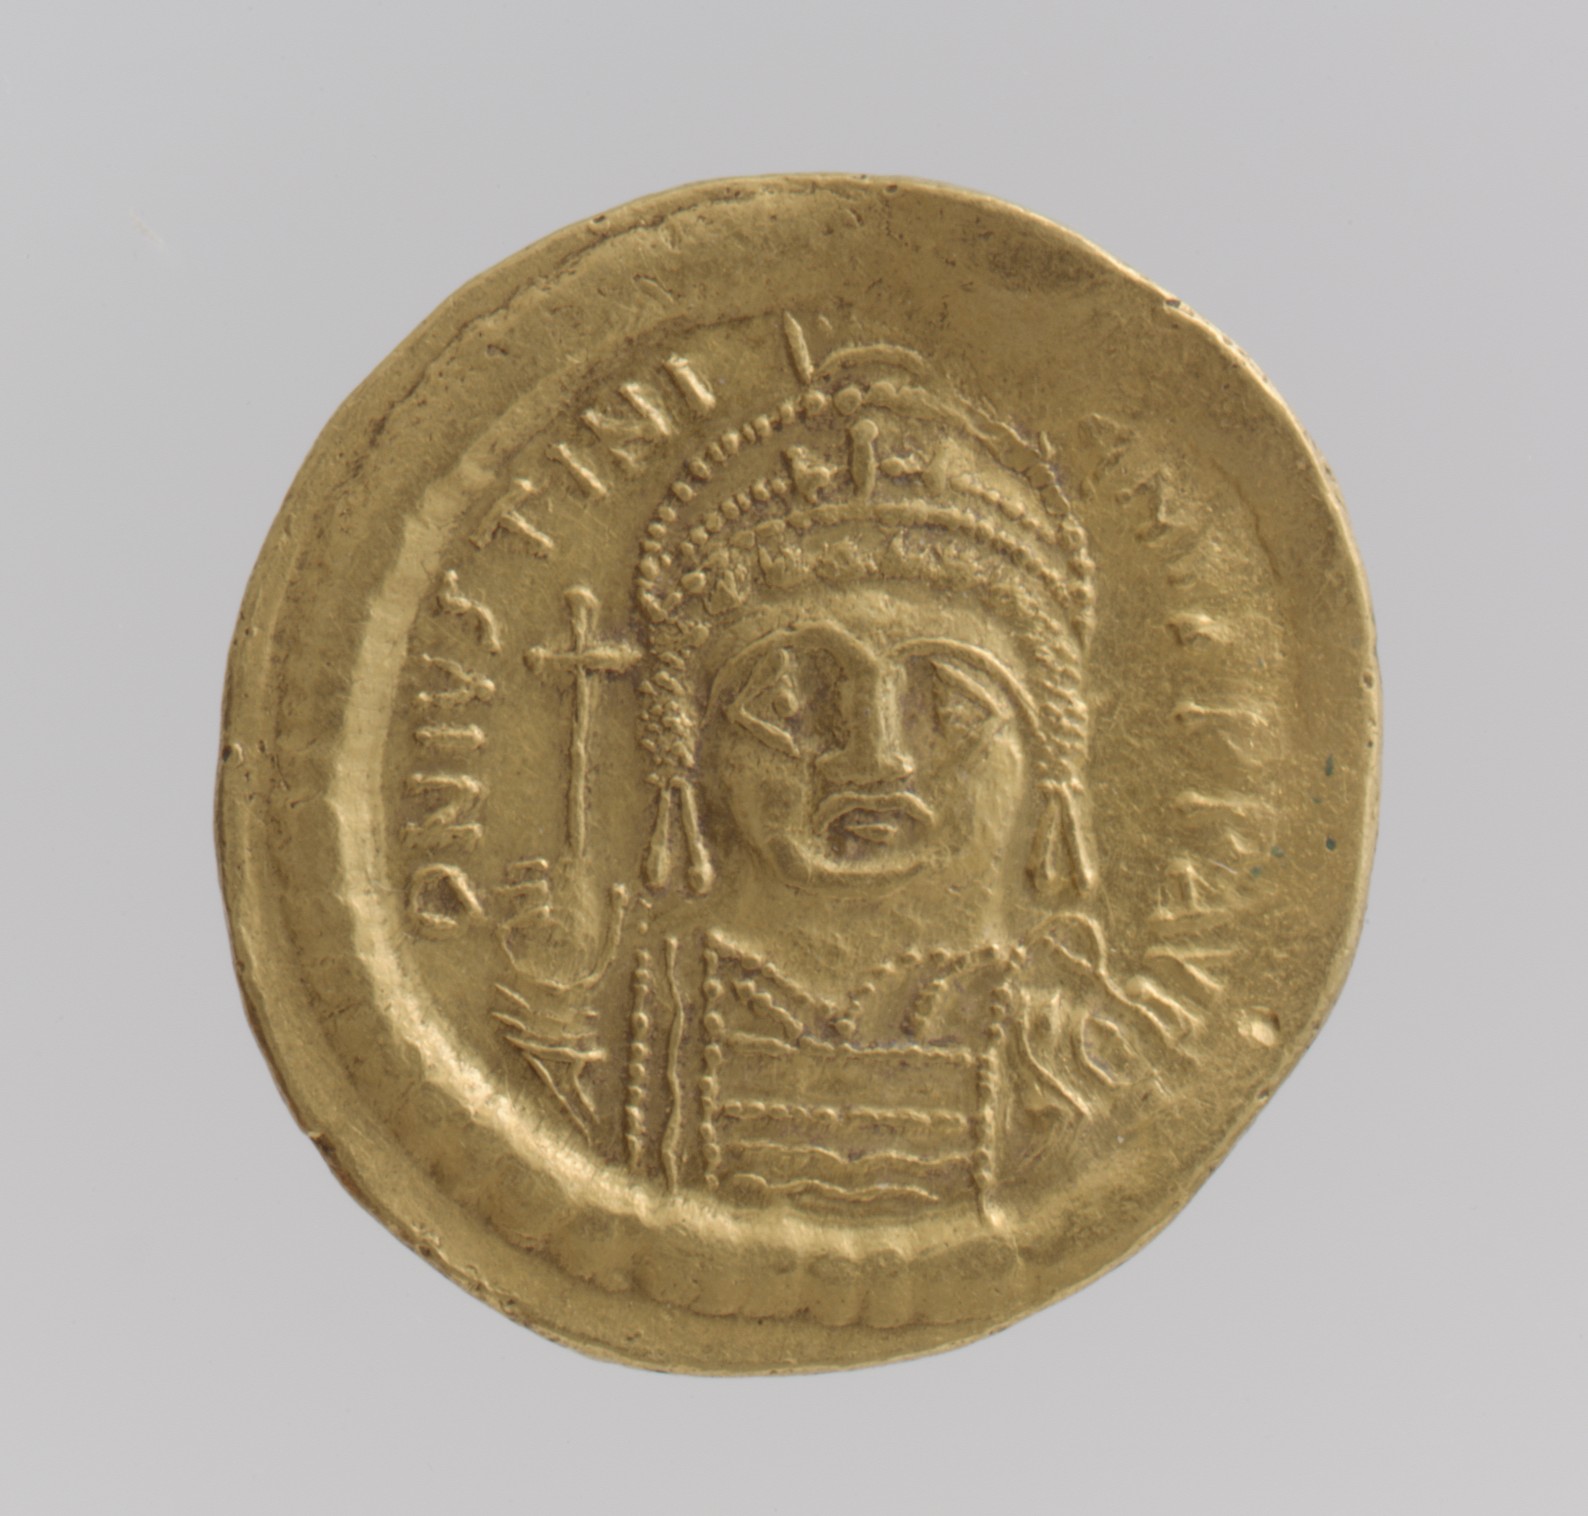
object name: solidus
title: Gold Solidus of Justinian I (527–65)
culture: byzantine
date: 538-565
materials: gold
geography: constantinople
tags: emperors,men